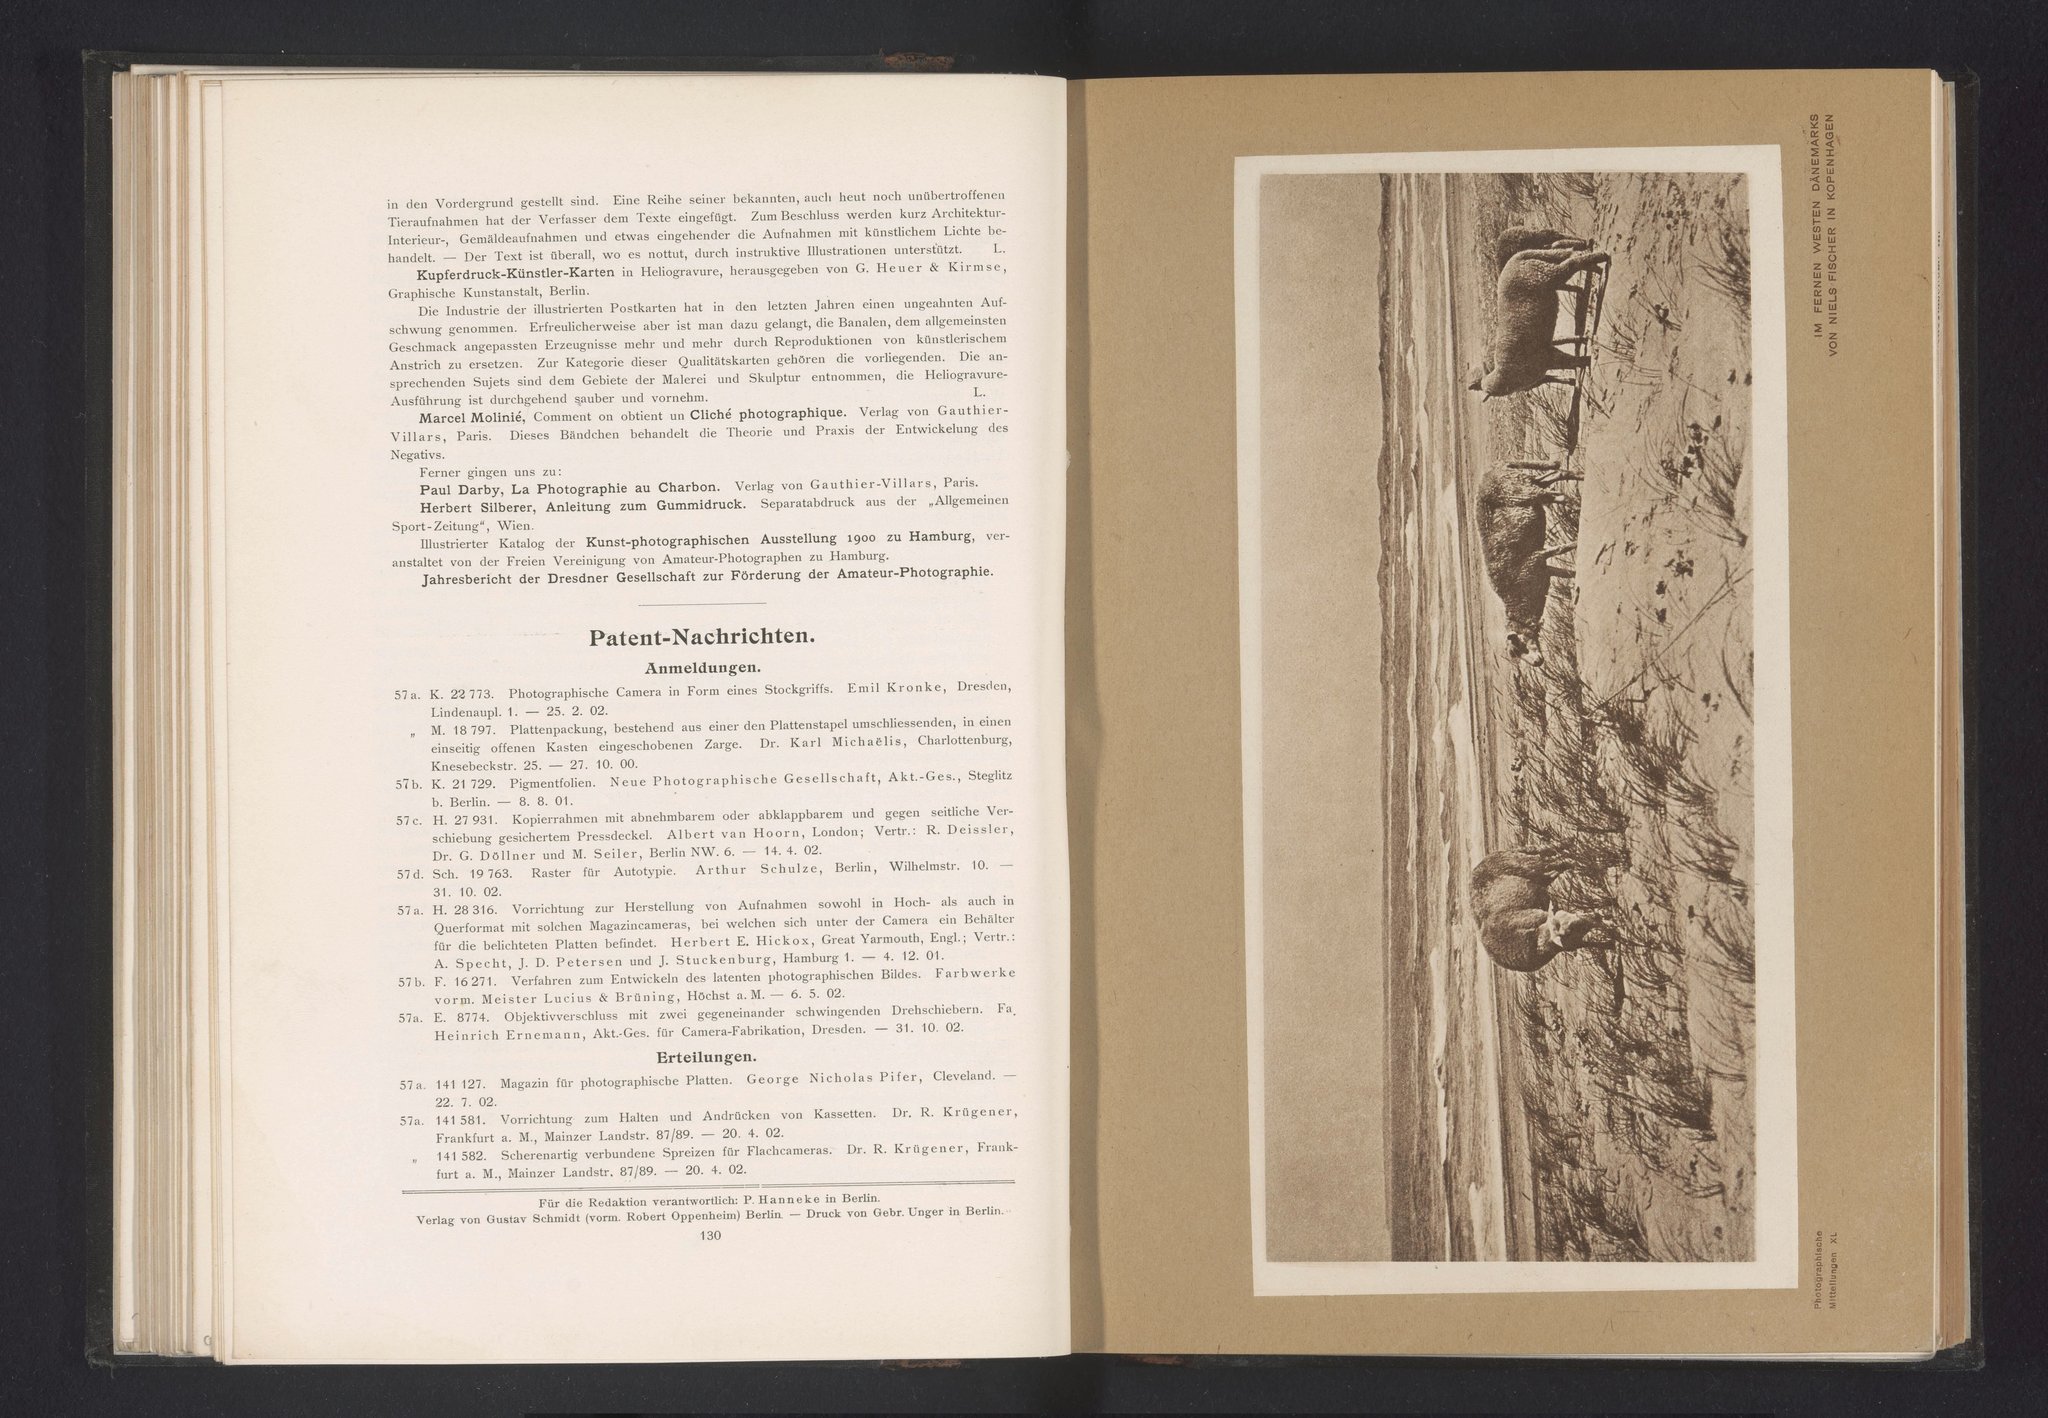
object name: photomechanical print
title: Vier schapen in de duinen aan zee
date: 1898-1903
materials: paper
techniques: photoaquatint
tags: dune coast, sheep, sea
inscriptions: inscription: ‘Photographische Mitteilungen XL’